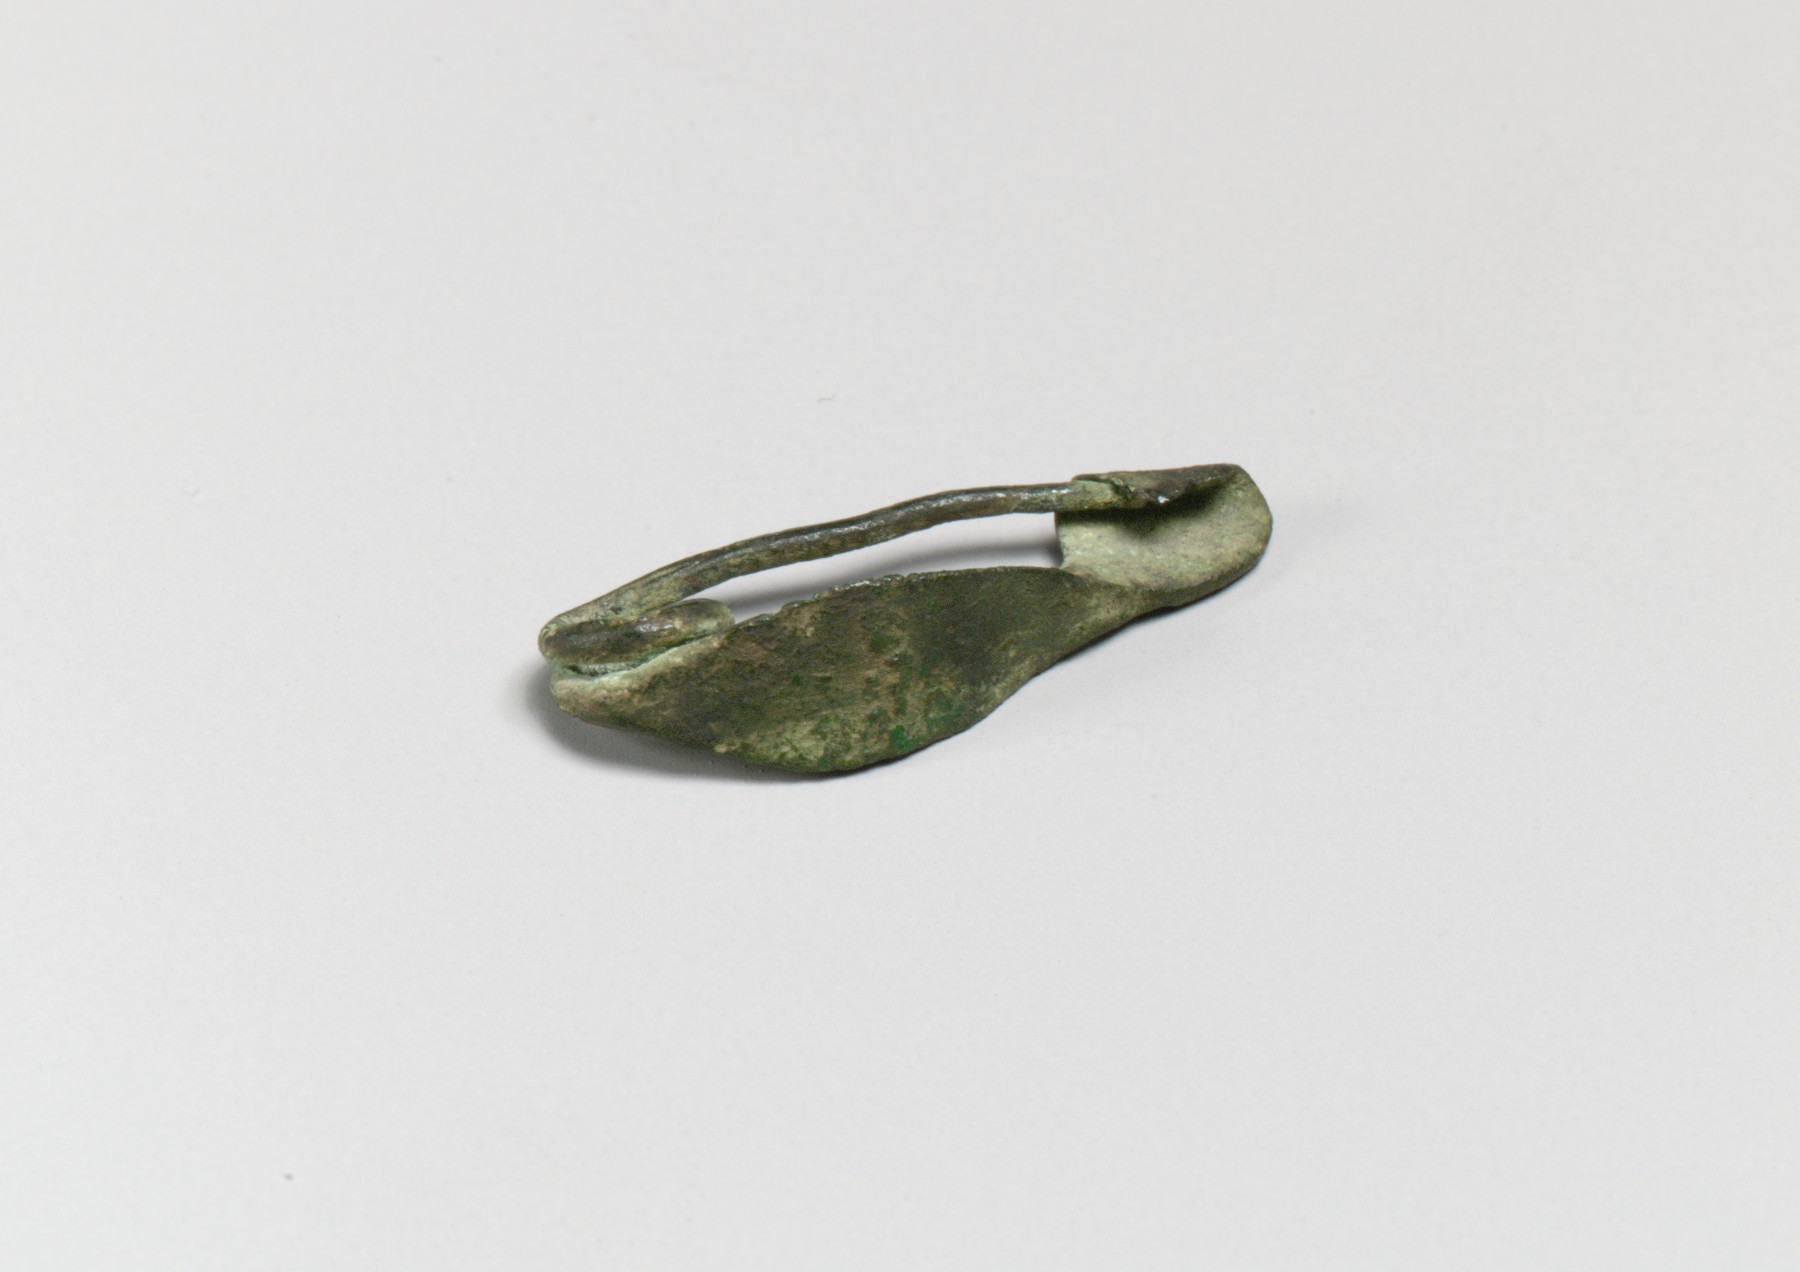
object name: fibula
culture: italic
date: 900-501 BCE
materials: bronze